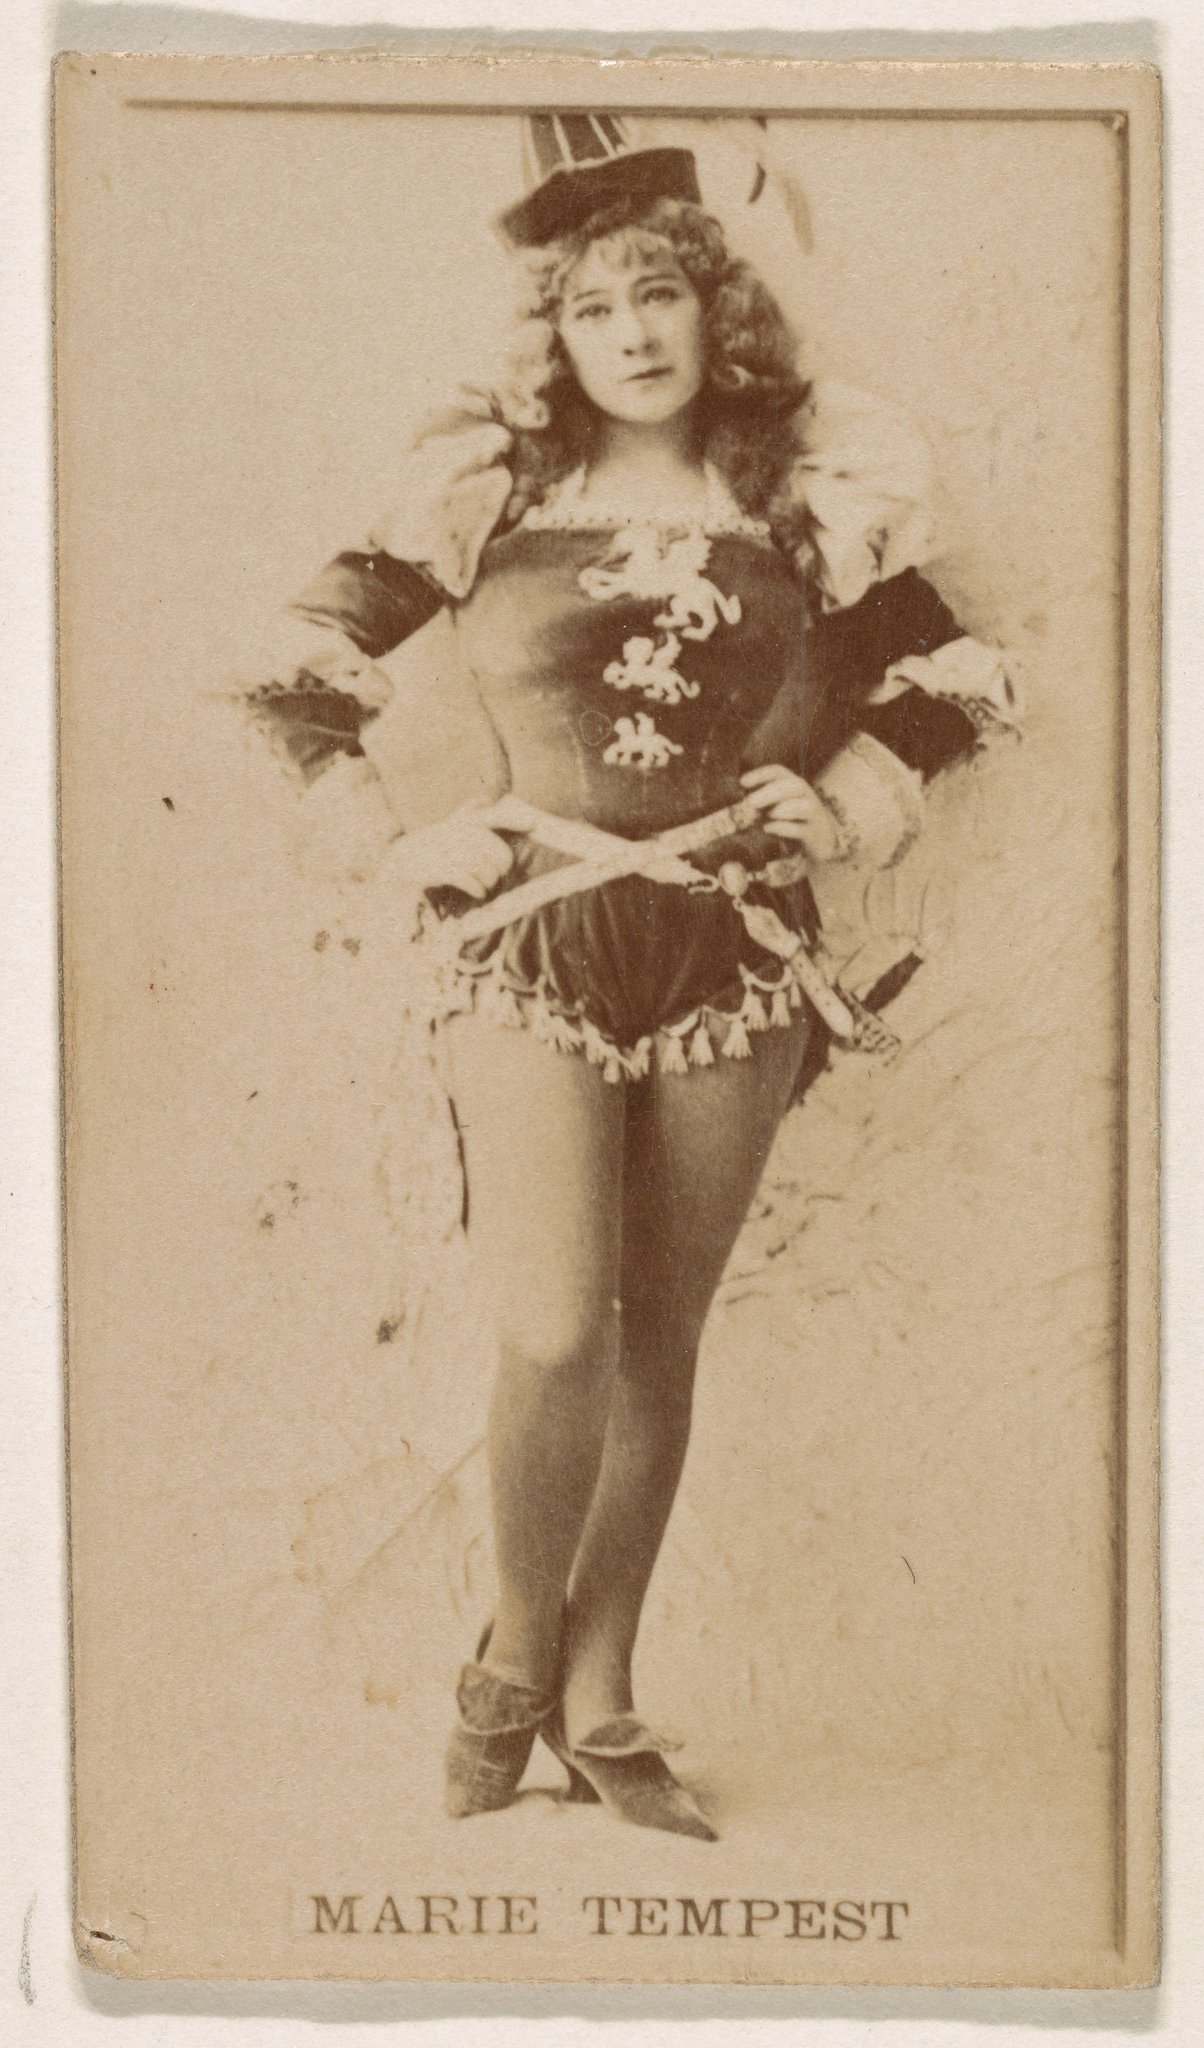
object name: photograph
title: Marie Tempest, from the Actresses series (N245) issued by Kinney Brothers to promote Sweet Caporal Cigarettes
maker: kinney brothers tobacco company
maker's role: publisher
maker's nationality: american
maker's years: 1869-2011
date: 1890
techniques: albumen silver print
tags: portraits,women,actresses